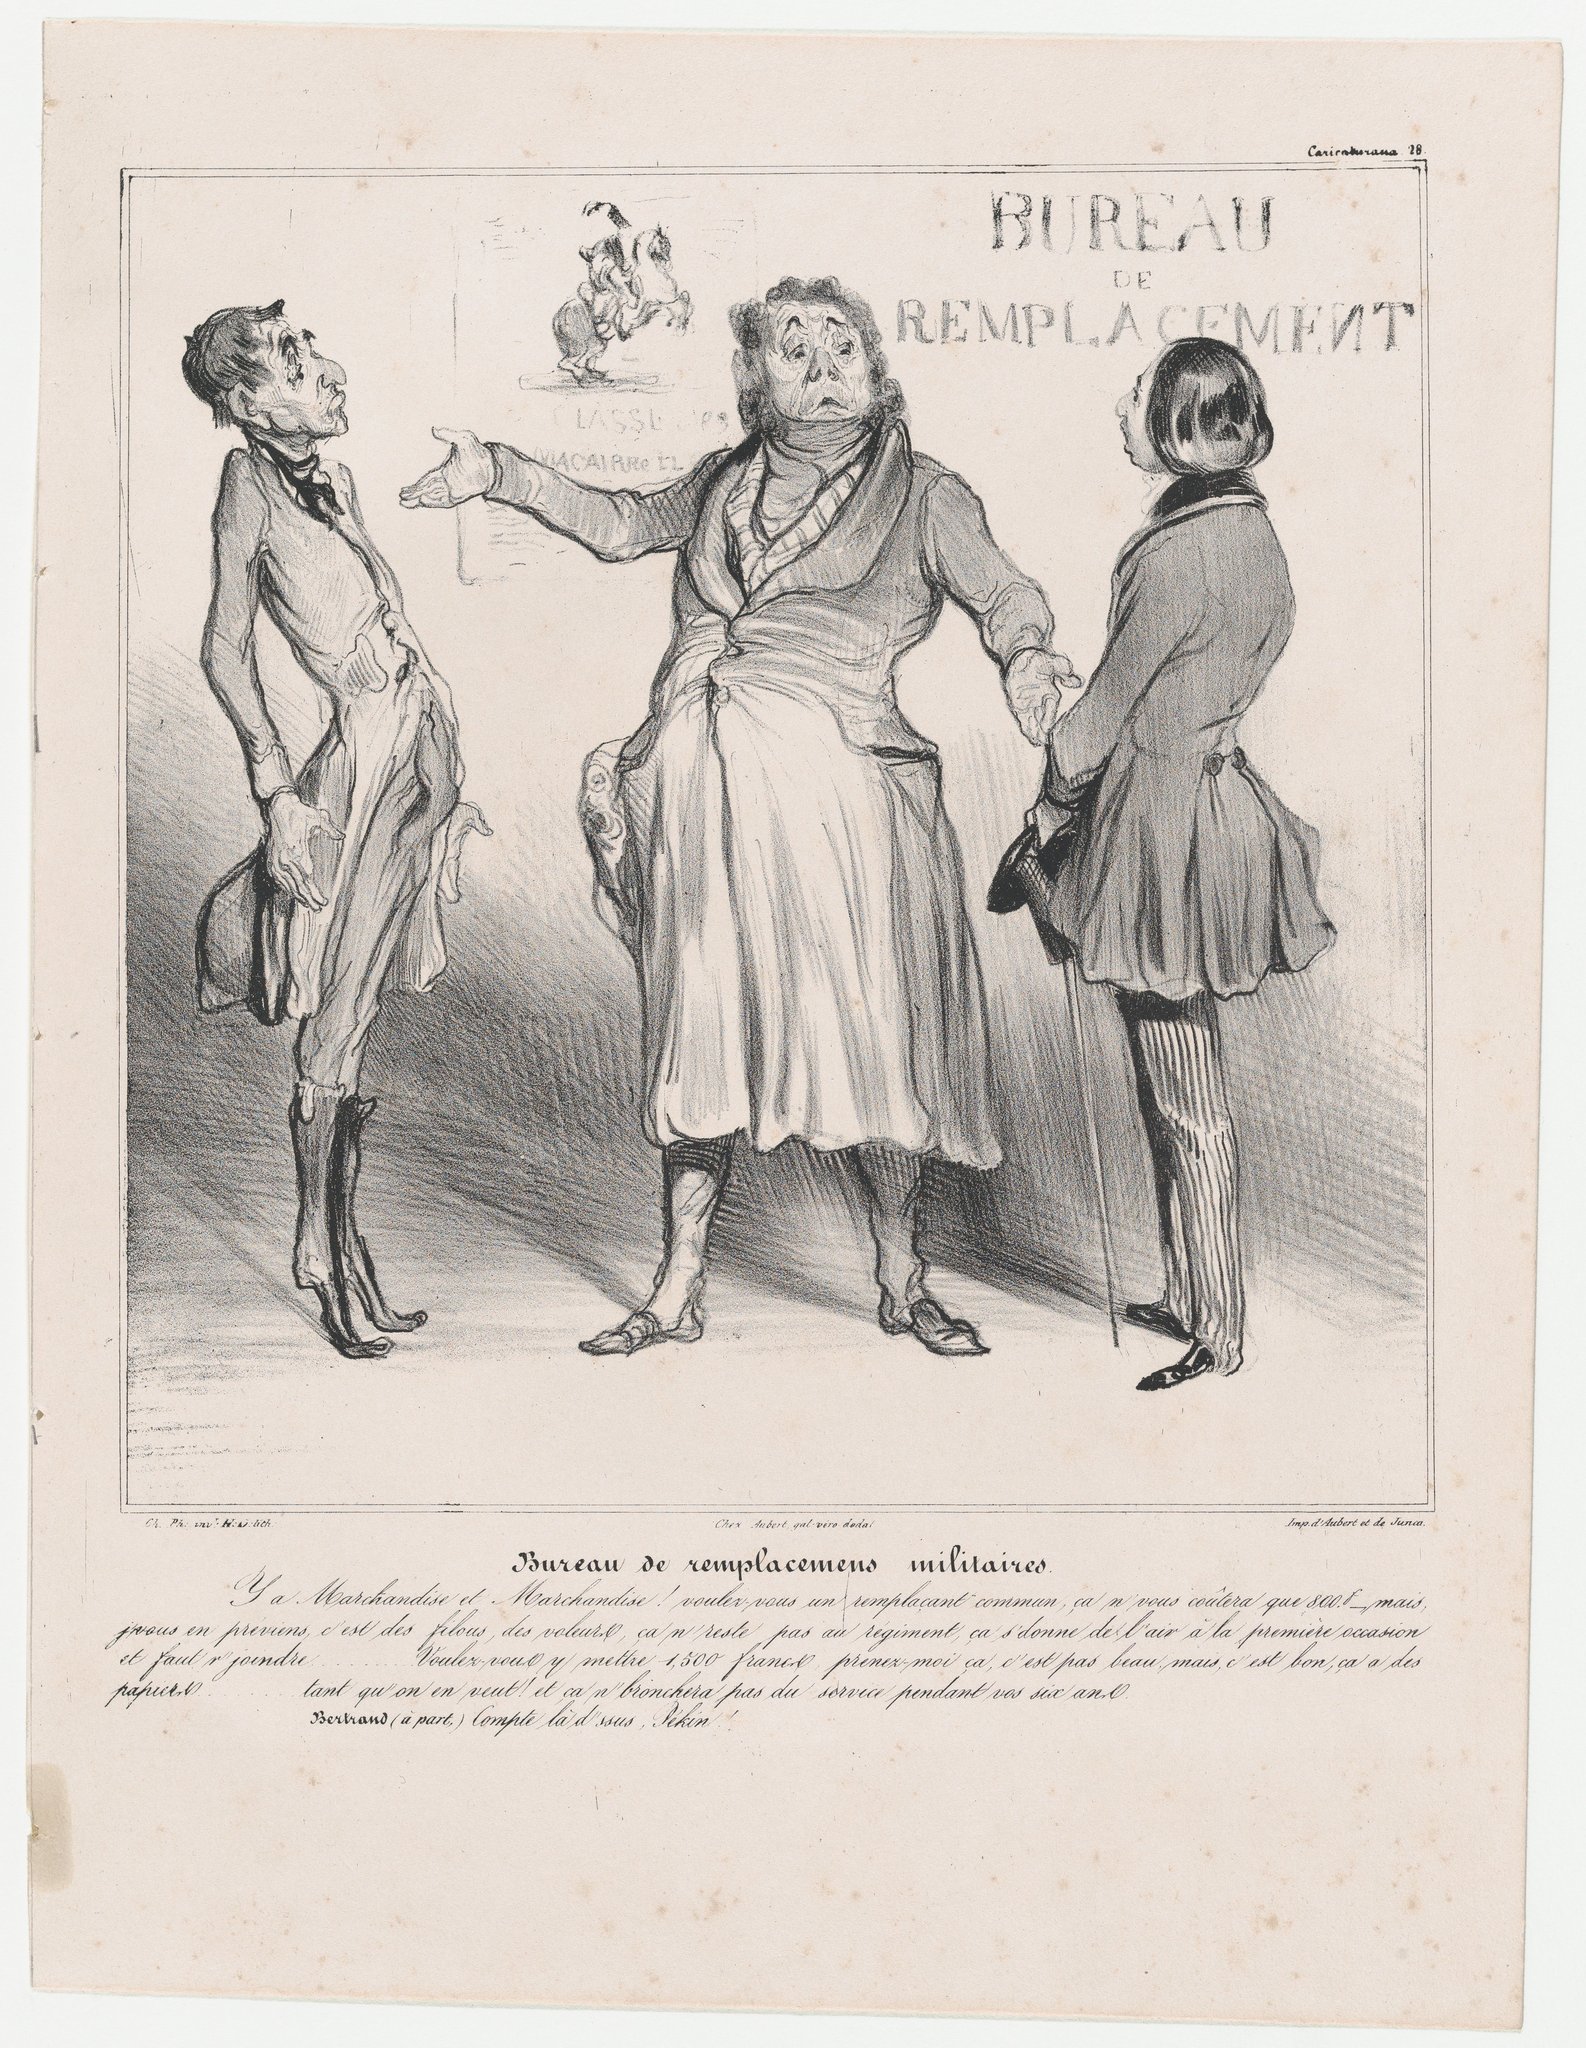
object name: print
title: Plate 28: Conscript replacement agency, from 'Caricaturana,' published in Les Robert Macaires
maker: honoré daumier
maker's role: artist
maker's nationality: french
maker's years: 1808-1879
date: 1838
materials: paper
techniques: lithograph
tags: satire,men,women